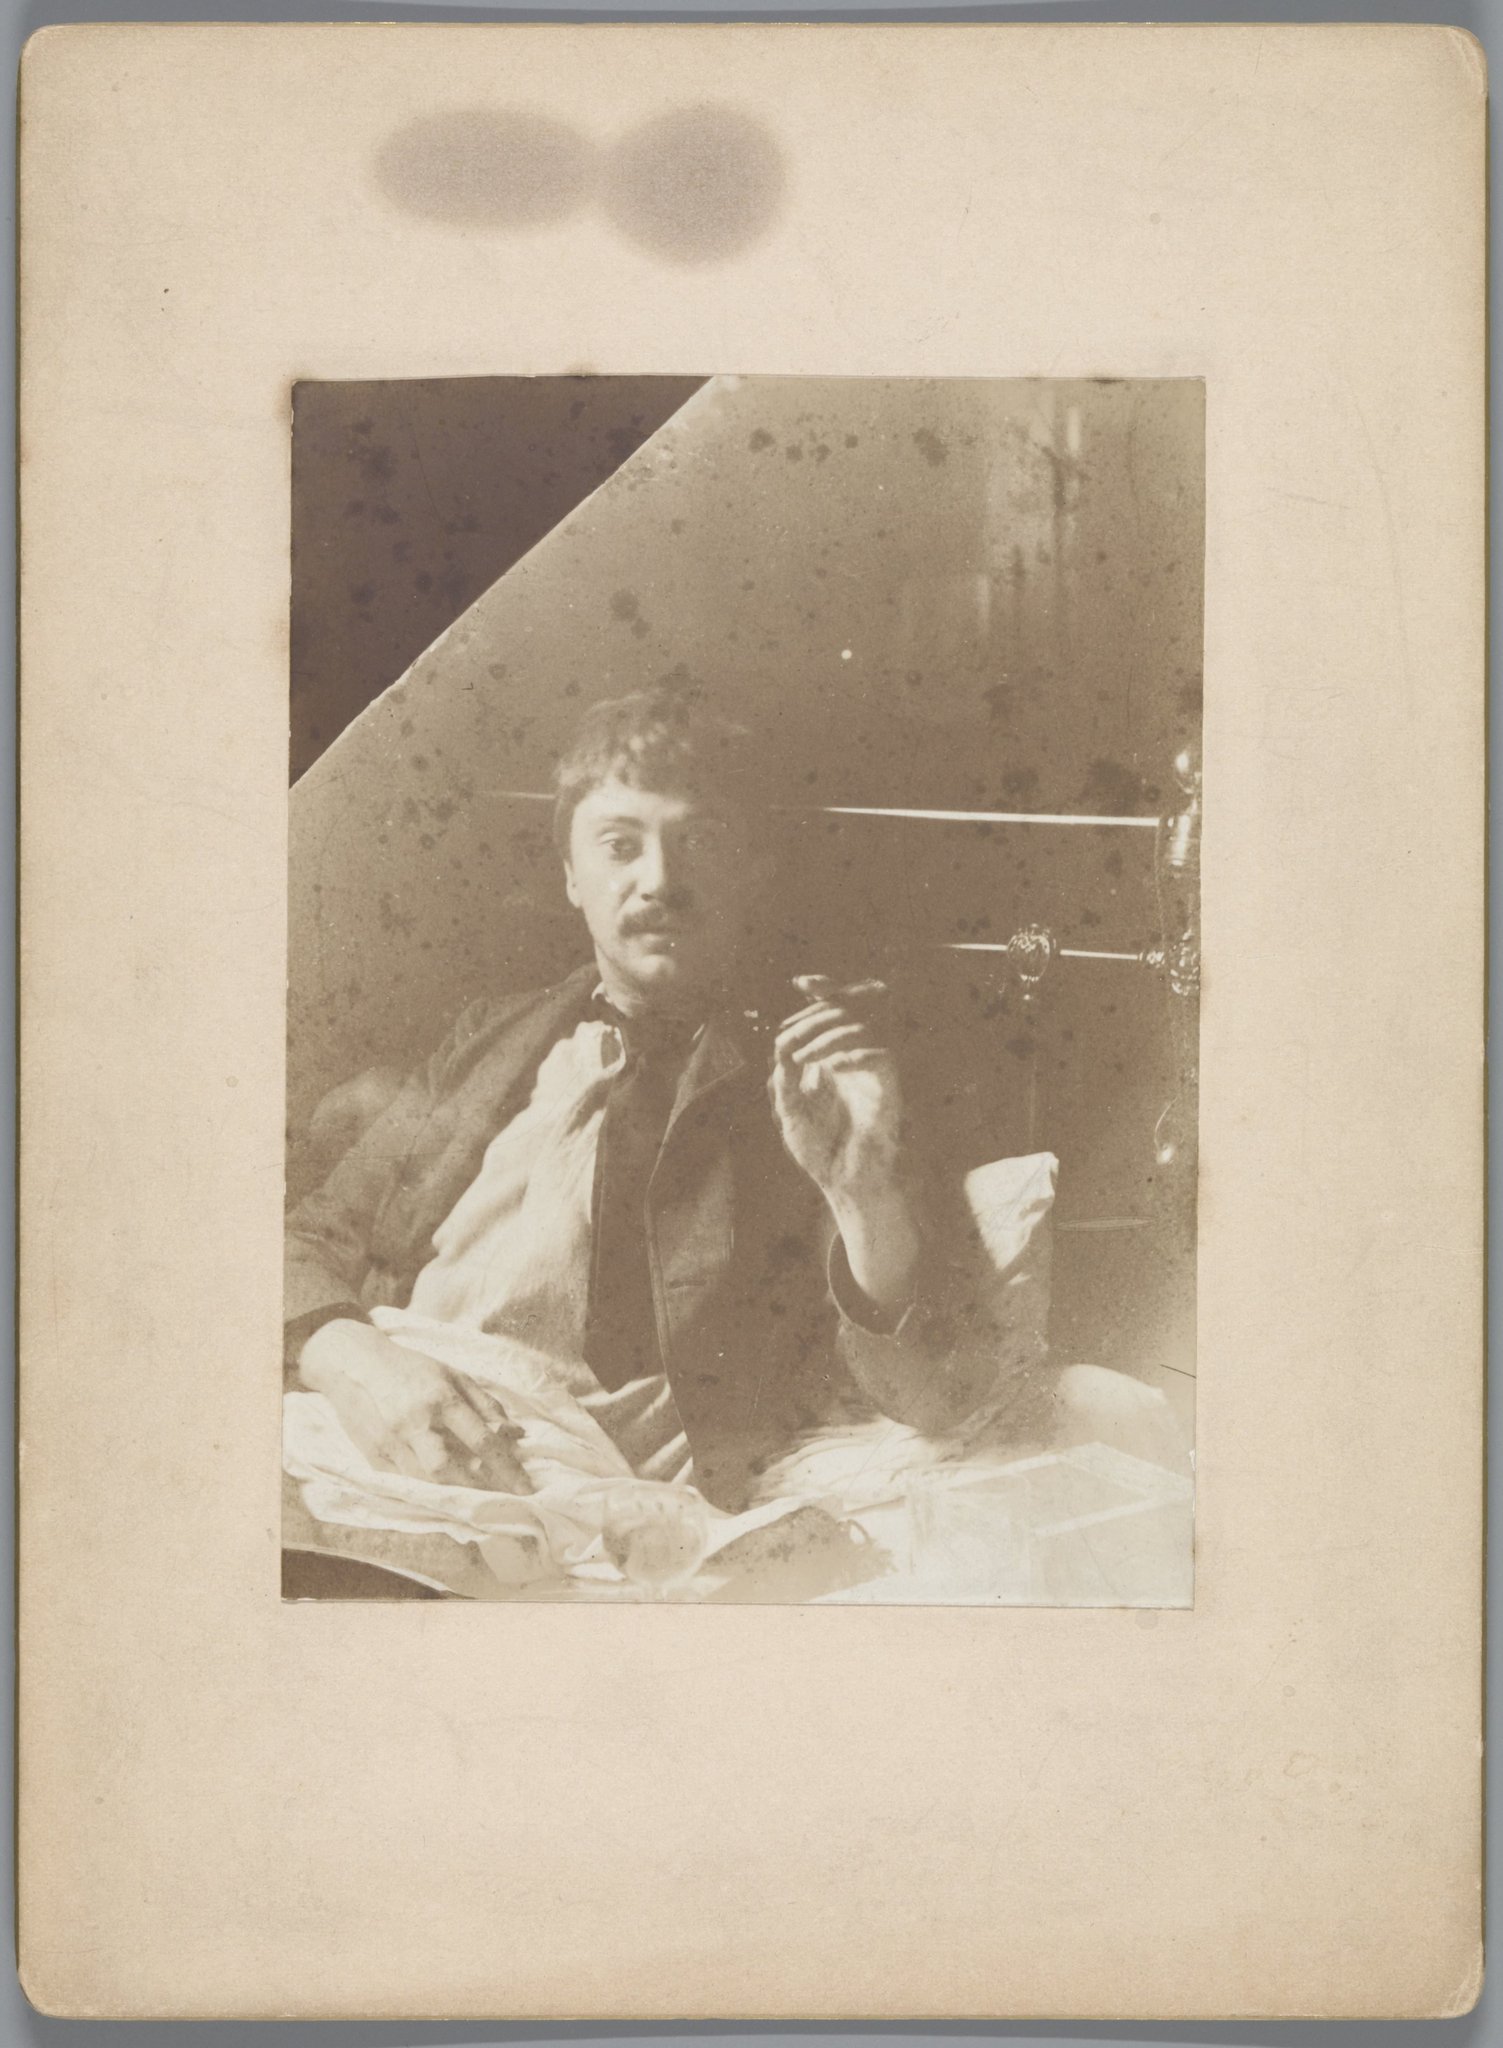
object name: photograph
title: Willem Witsen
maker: Anonymous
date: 1860-1915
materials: paper, photographic support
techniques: albumen print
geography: amsterdam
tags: amsterdam, painter, print maker, draughtsman, willem witsen